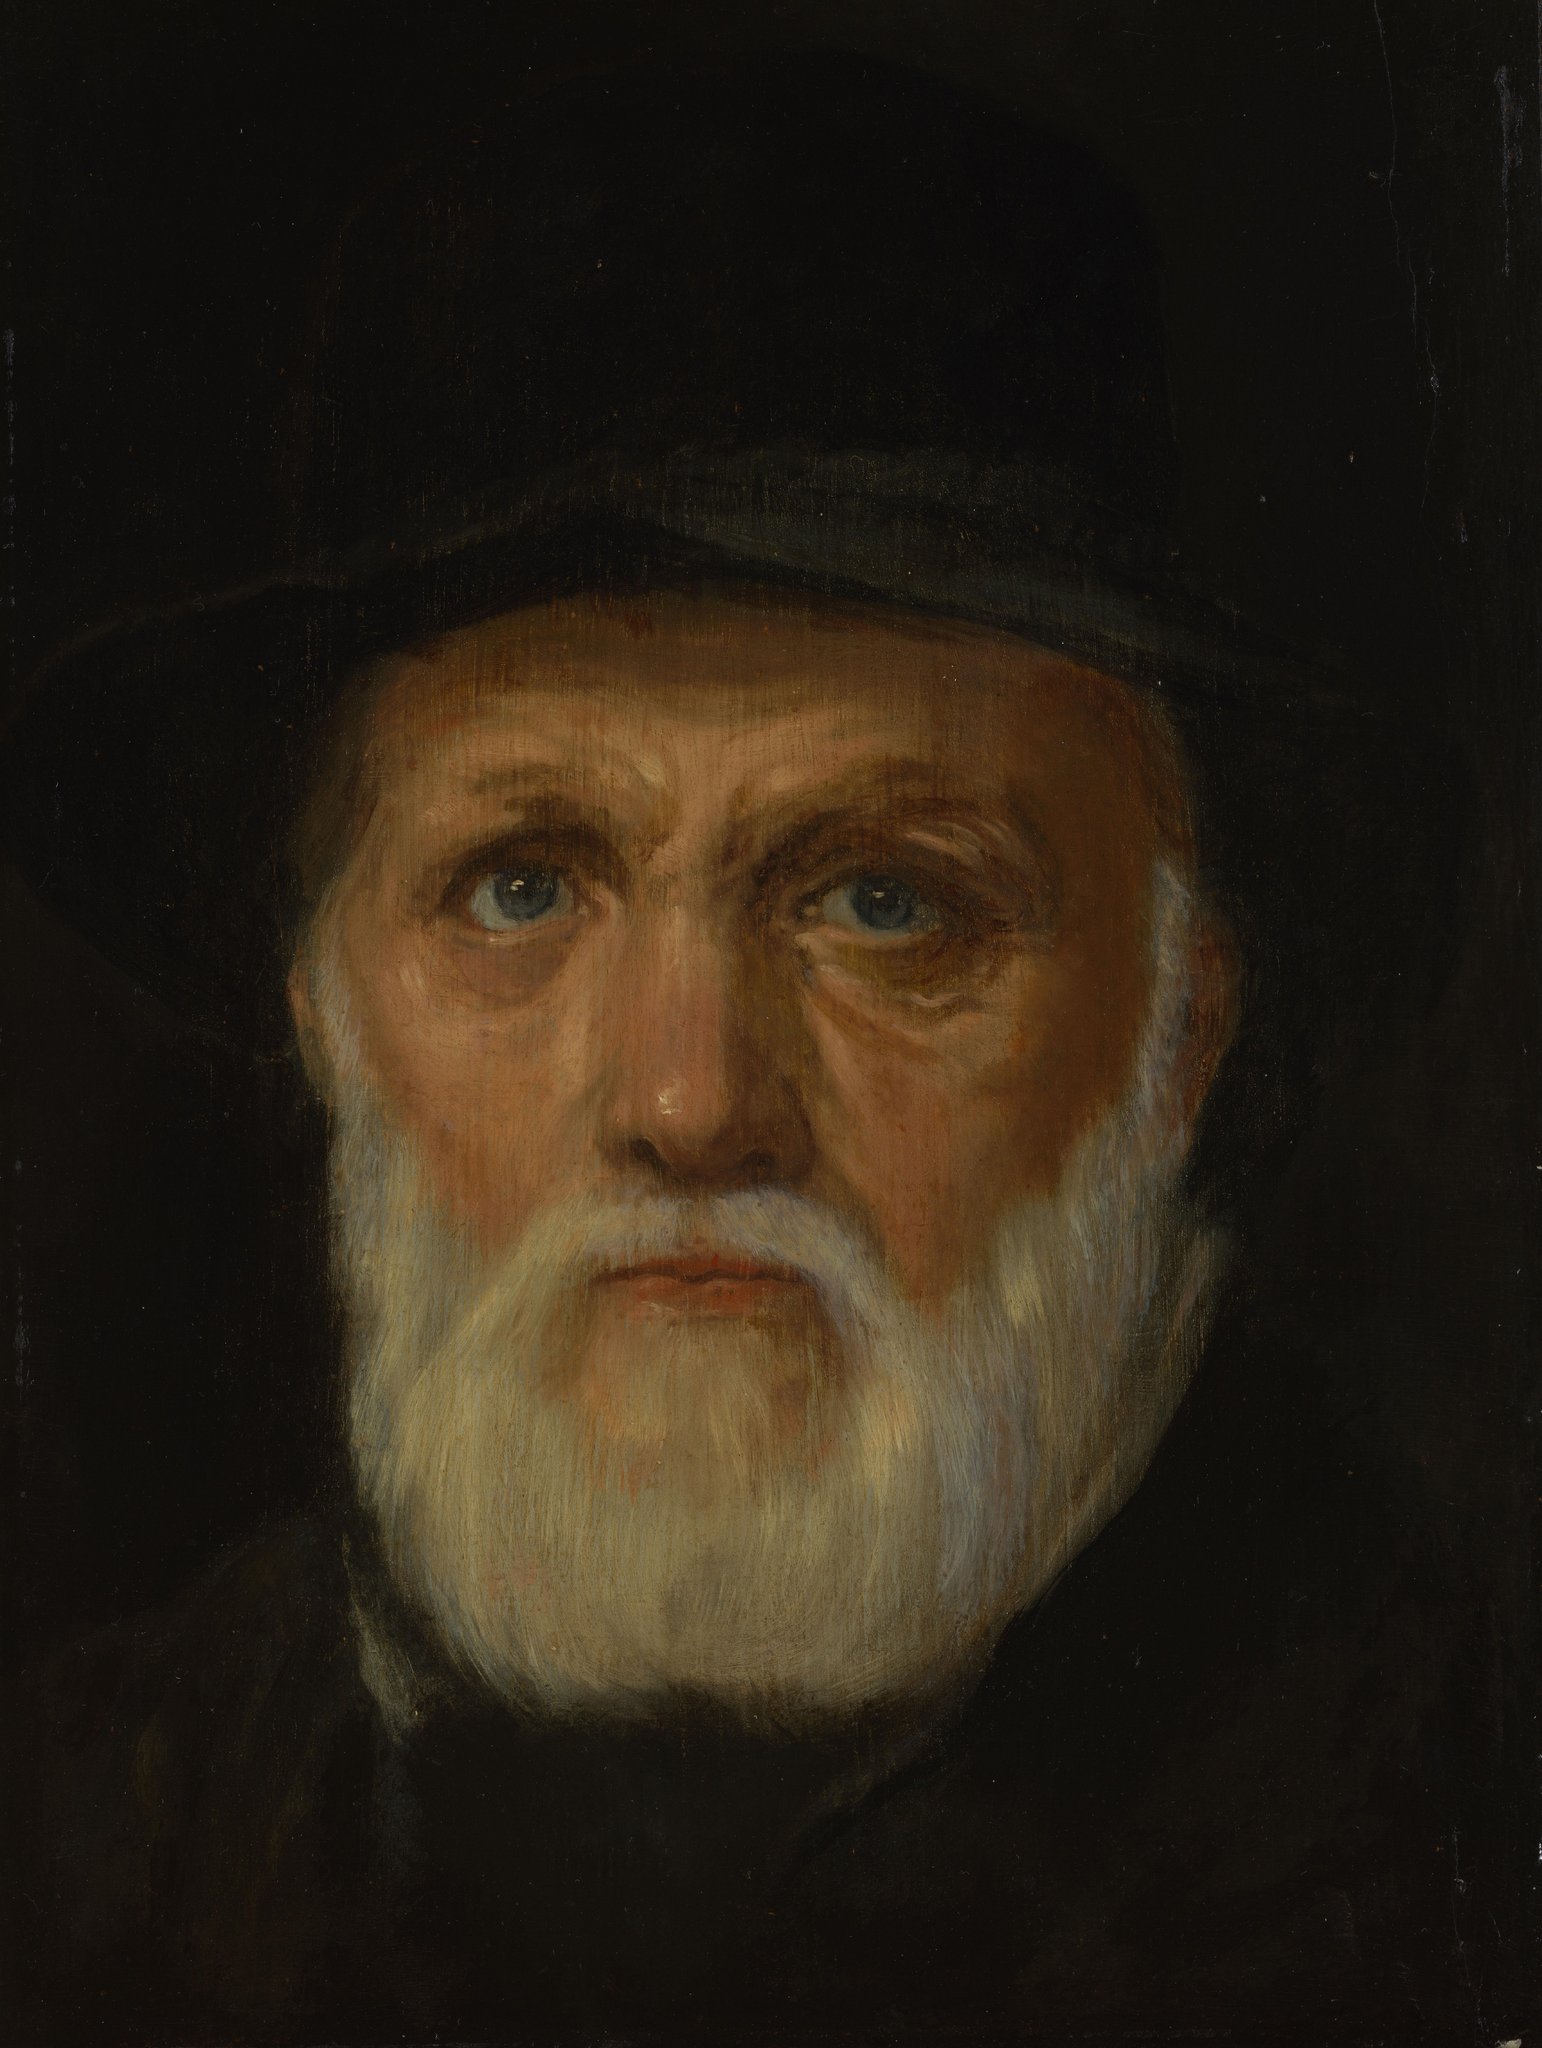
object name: painting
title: Dirck Volkertsz Coornhert (1522-90). Writer and Engraver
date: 1572-1600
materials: oil, panel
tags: amsterdam, gouda, draughtsman, dirck volckertsz. coornhert, scholar, philosopher, historical persons, portrait of a writer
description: Dirck Volkertsz Coornhert. Copy after Cornelis Cornelisz of Haarlem, last quarter 16th century. Coornhert (1522-1590) became town secretary of Haarlem in 1562. He belonged to the influential circle of humanist intellectuals associated with William of Orange. For Coornhert, tolerance and religious freedom were central tenets of the Dutch Revolt. This brought him into conflict with both Catholics and Protestants. When Spanish troops landed in the Netherlands in 1567, Coornhert was arrested as a suspected heretic. He managed to escape to Germany. Later, having returned to Haarlem, he was forced to flee again. This time from the Calvinists.